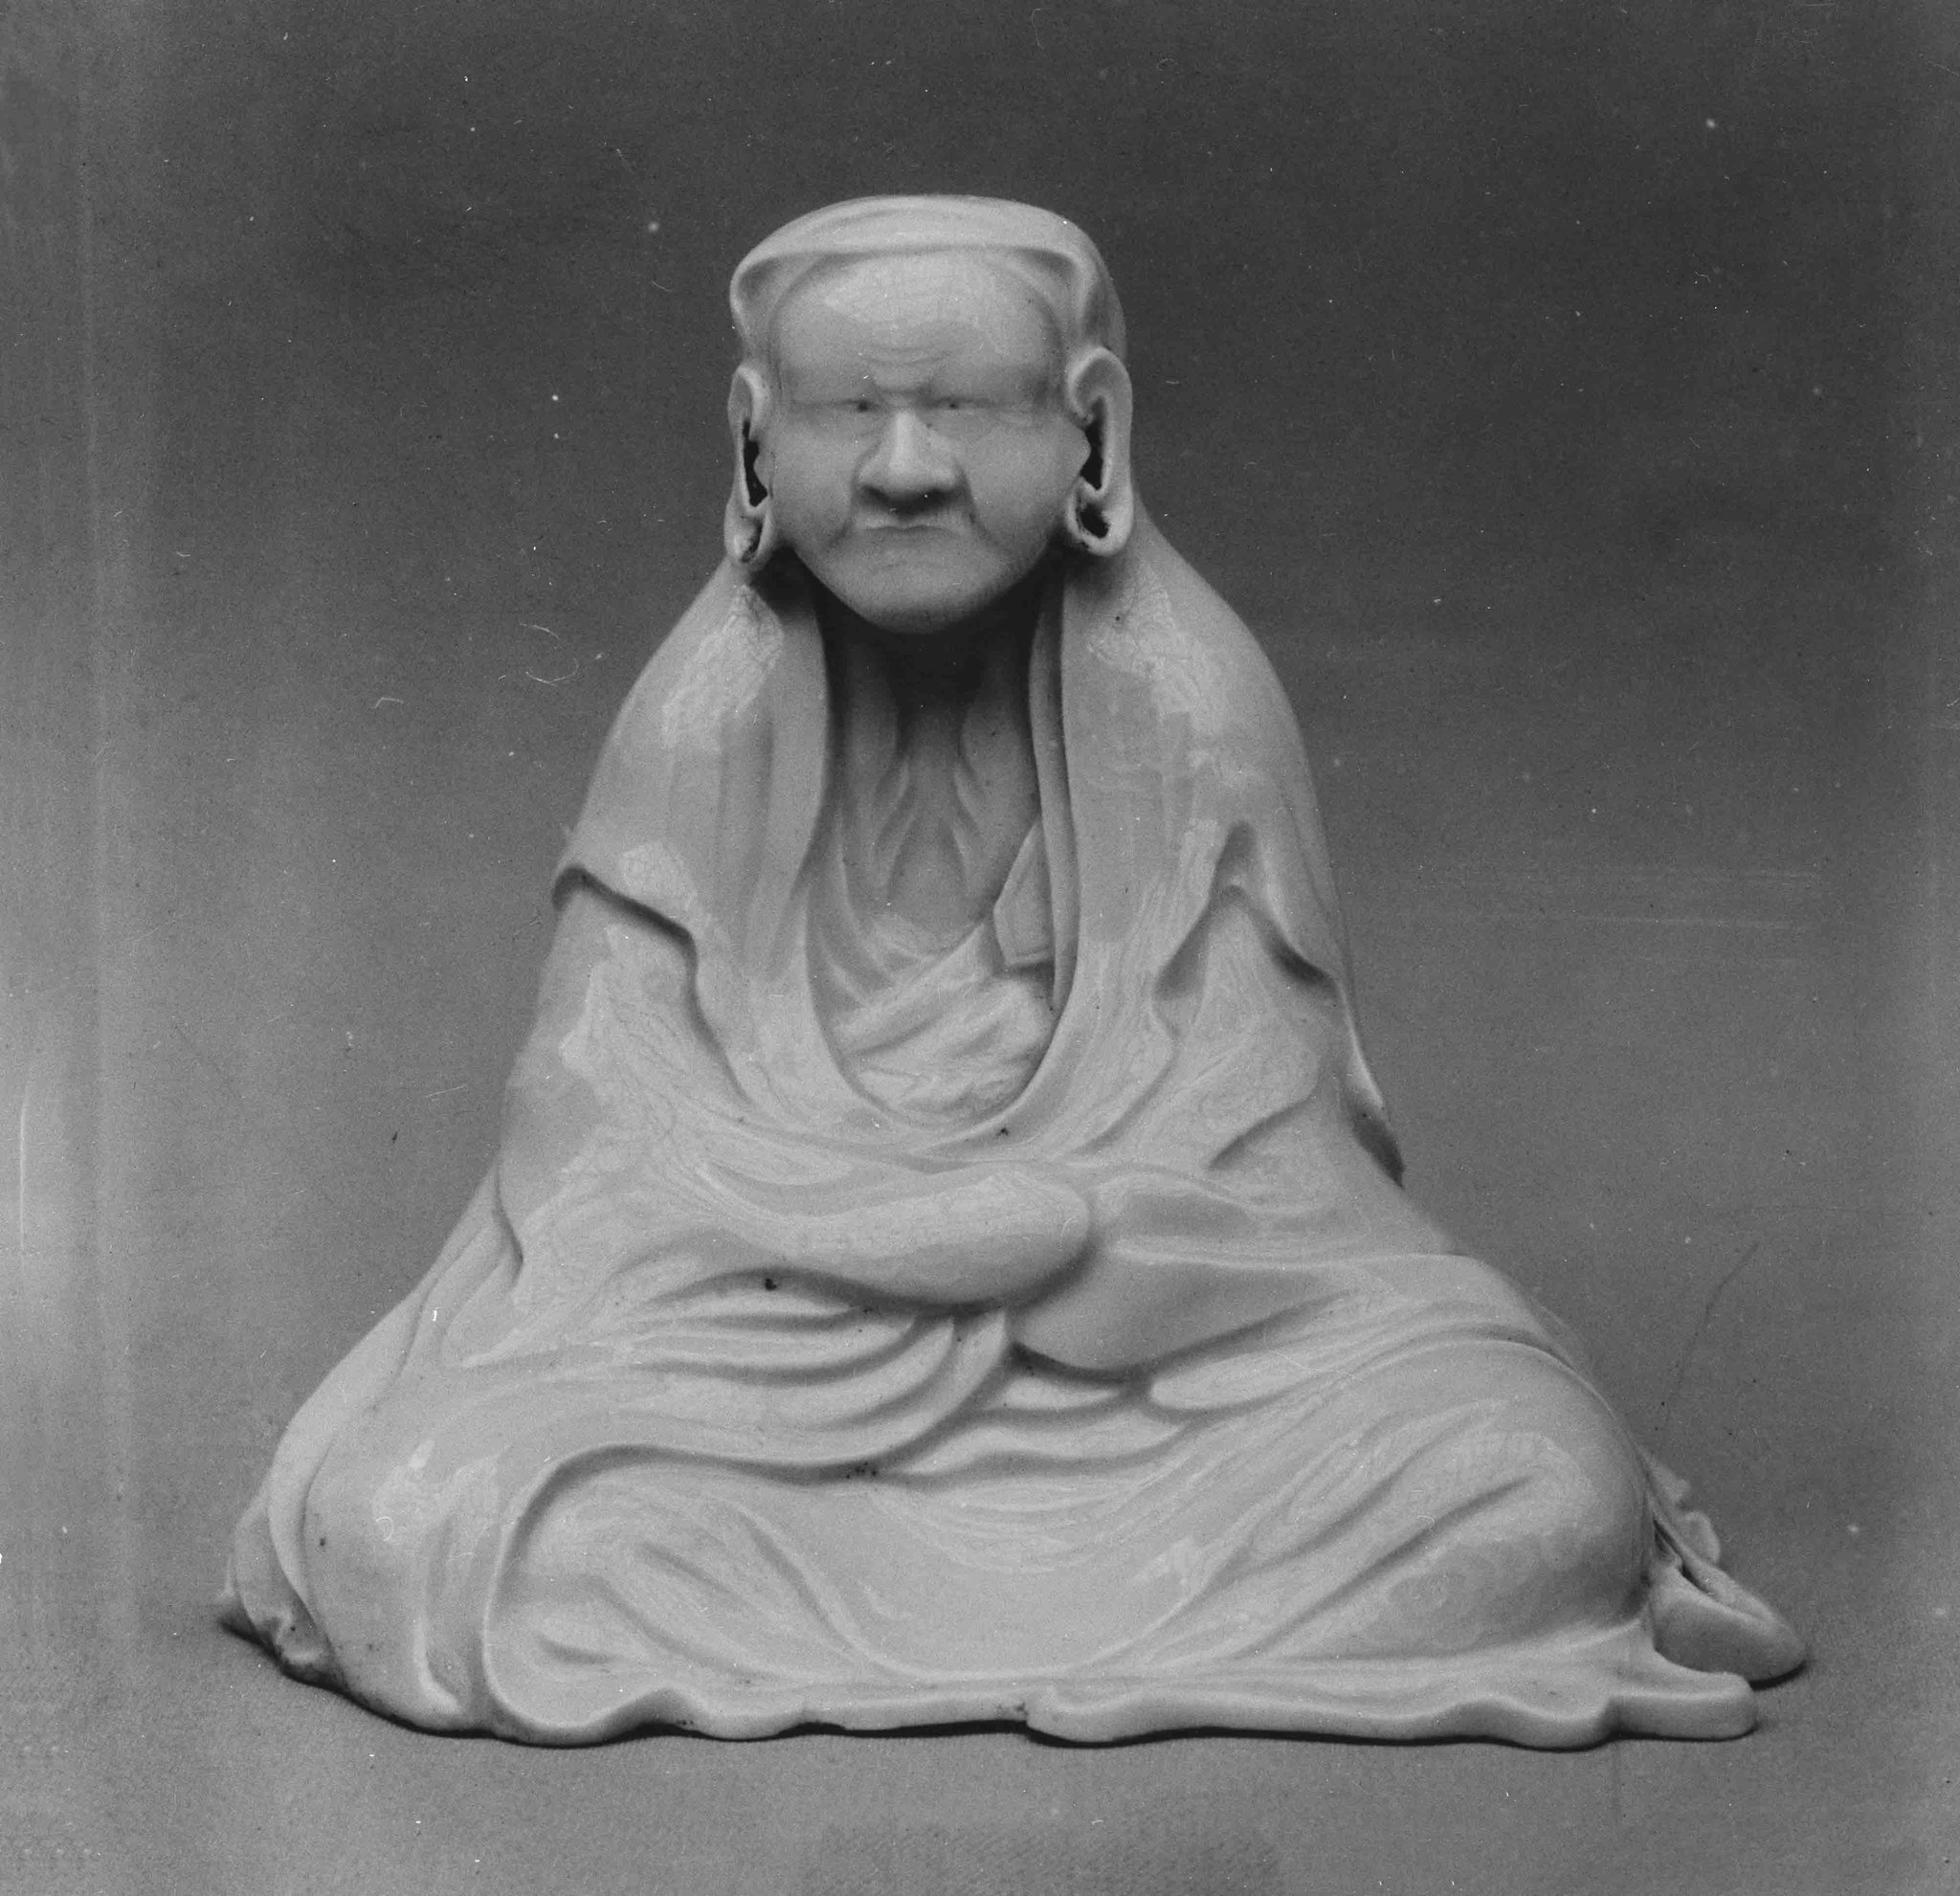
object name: figure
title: Figure of Daruma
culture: japanese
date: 1780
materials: glaze, porcelain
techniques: relief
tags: men,buddhism